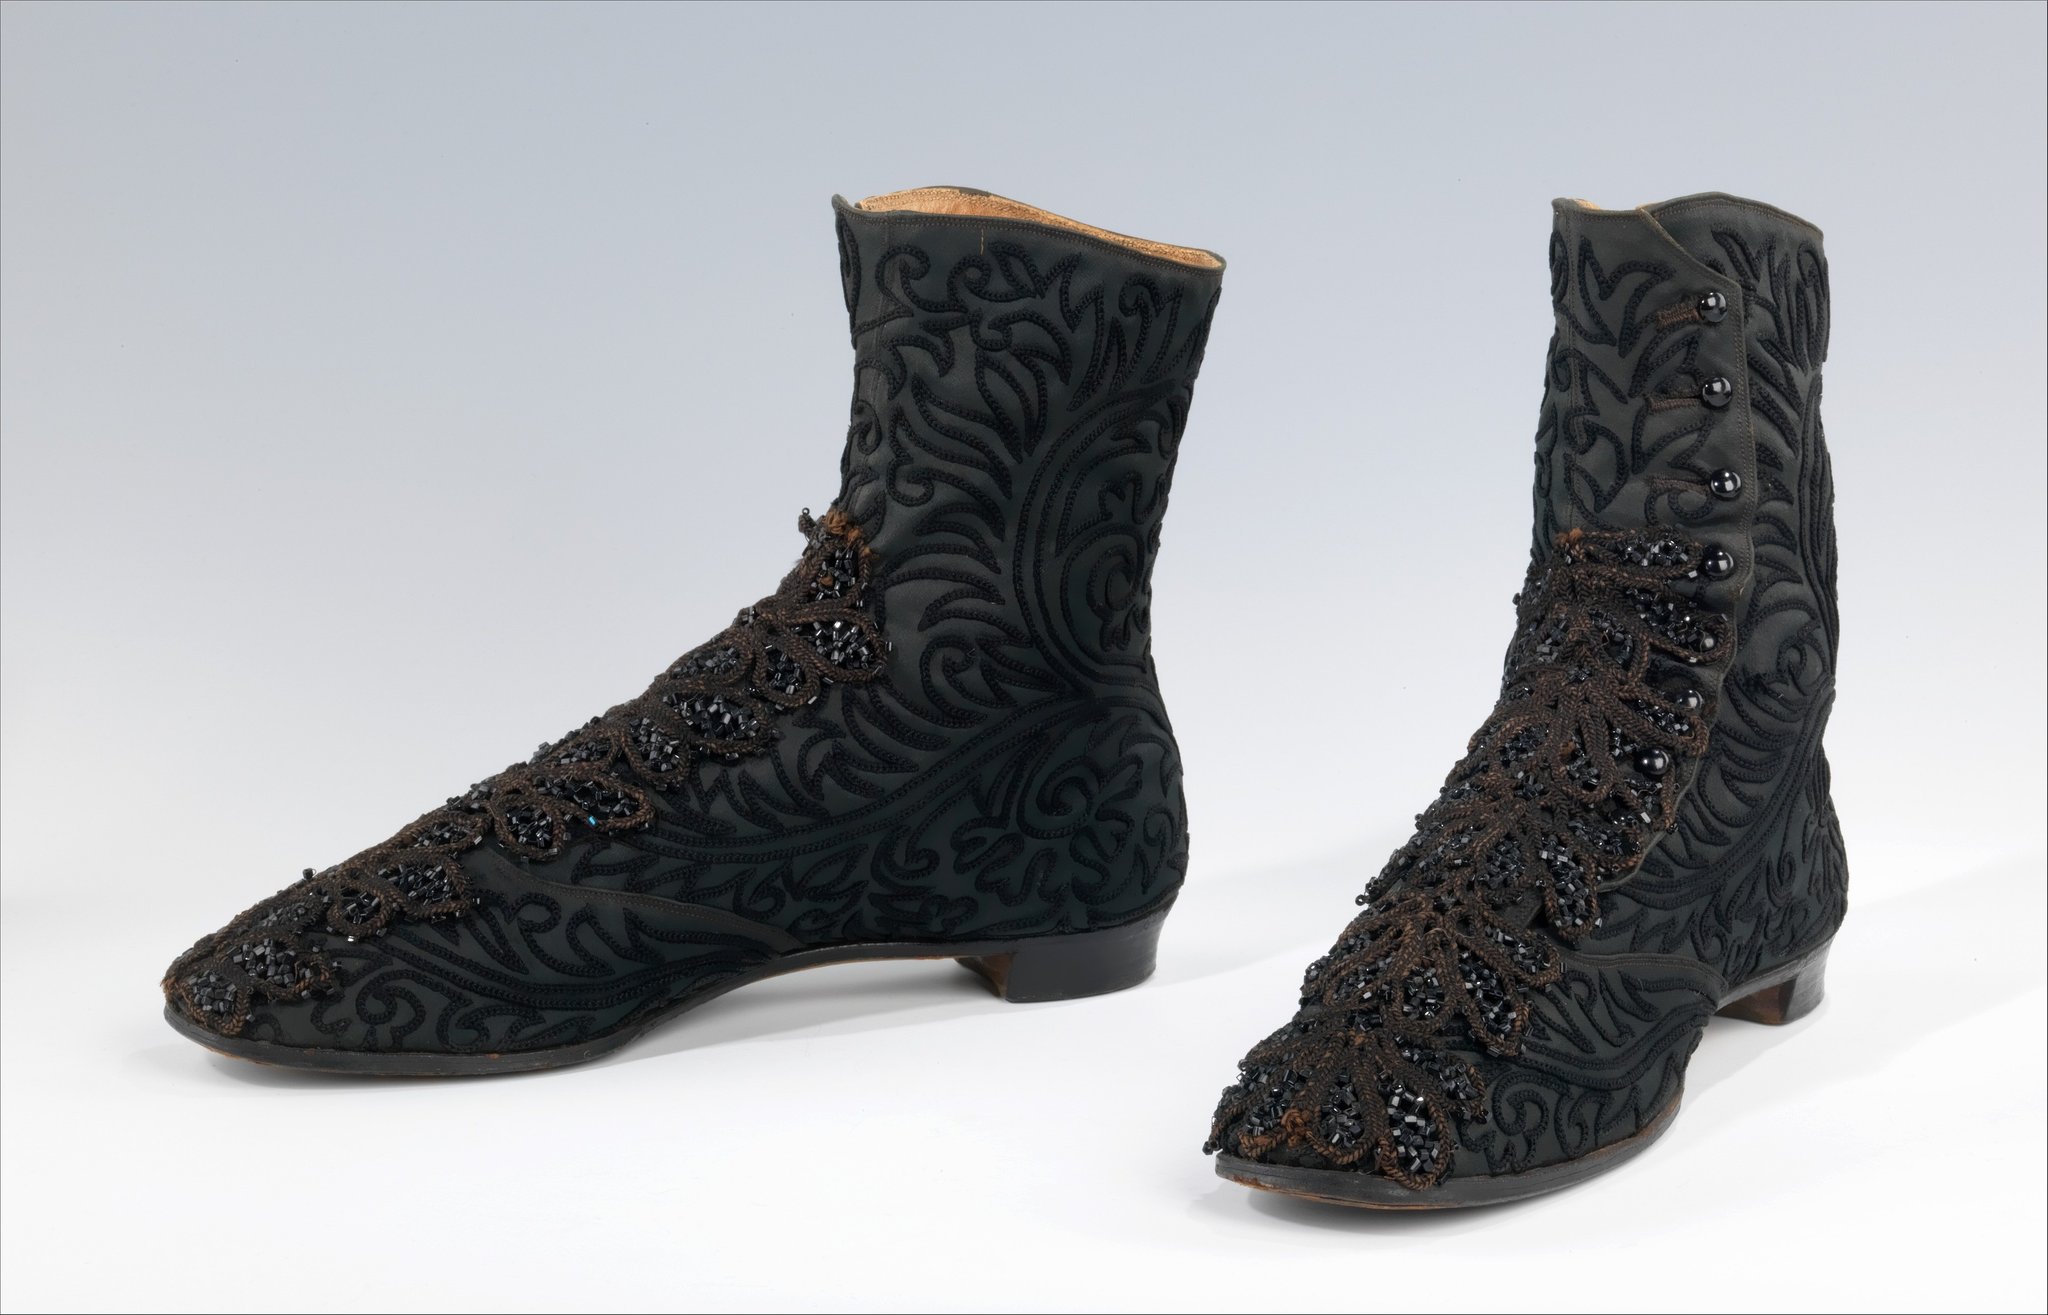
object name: boot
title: Boots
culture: american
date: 1865-1875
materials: cotton, silk, wool